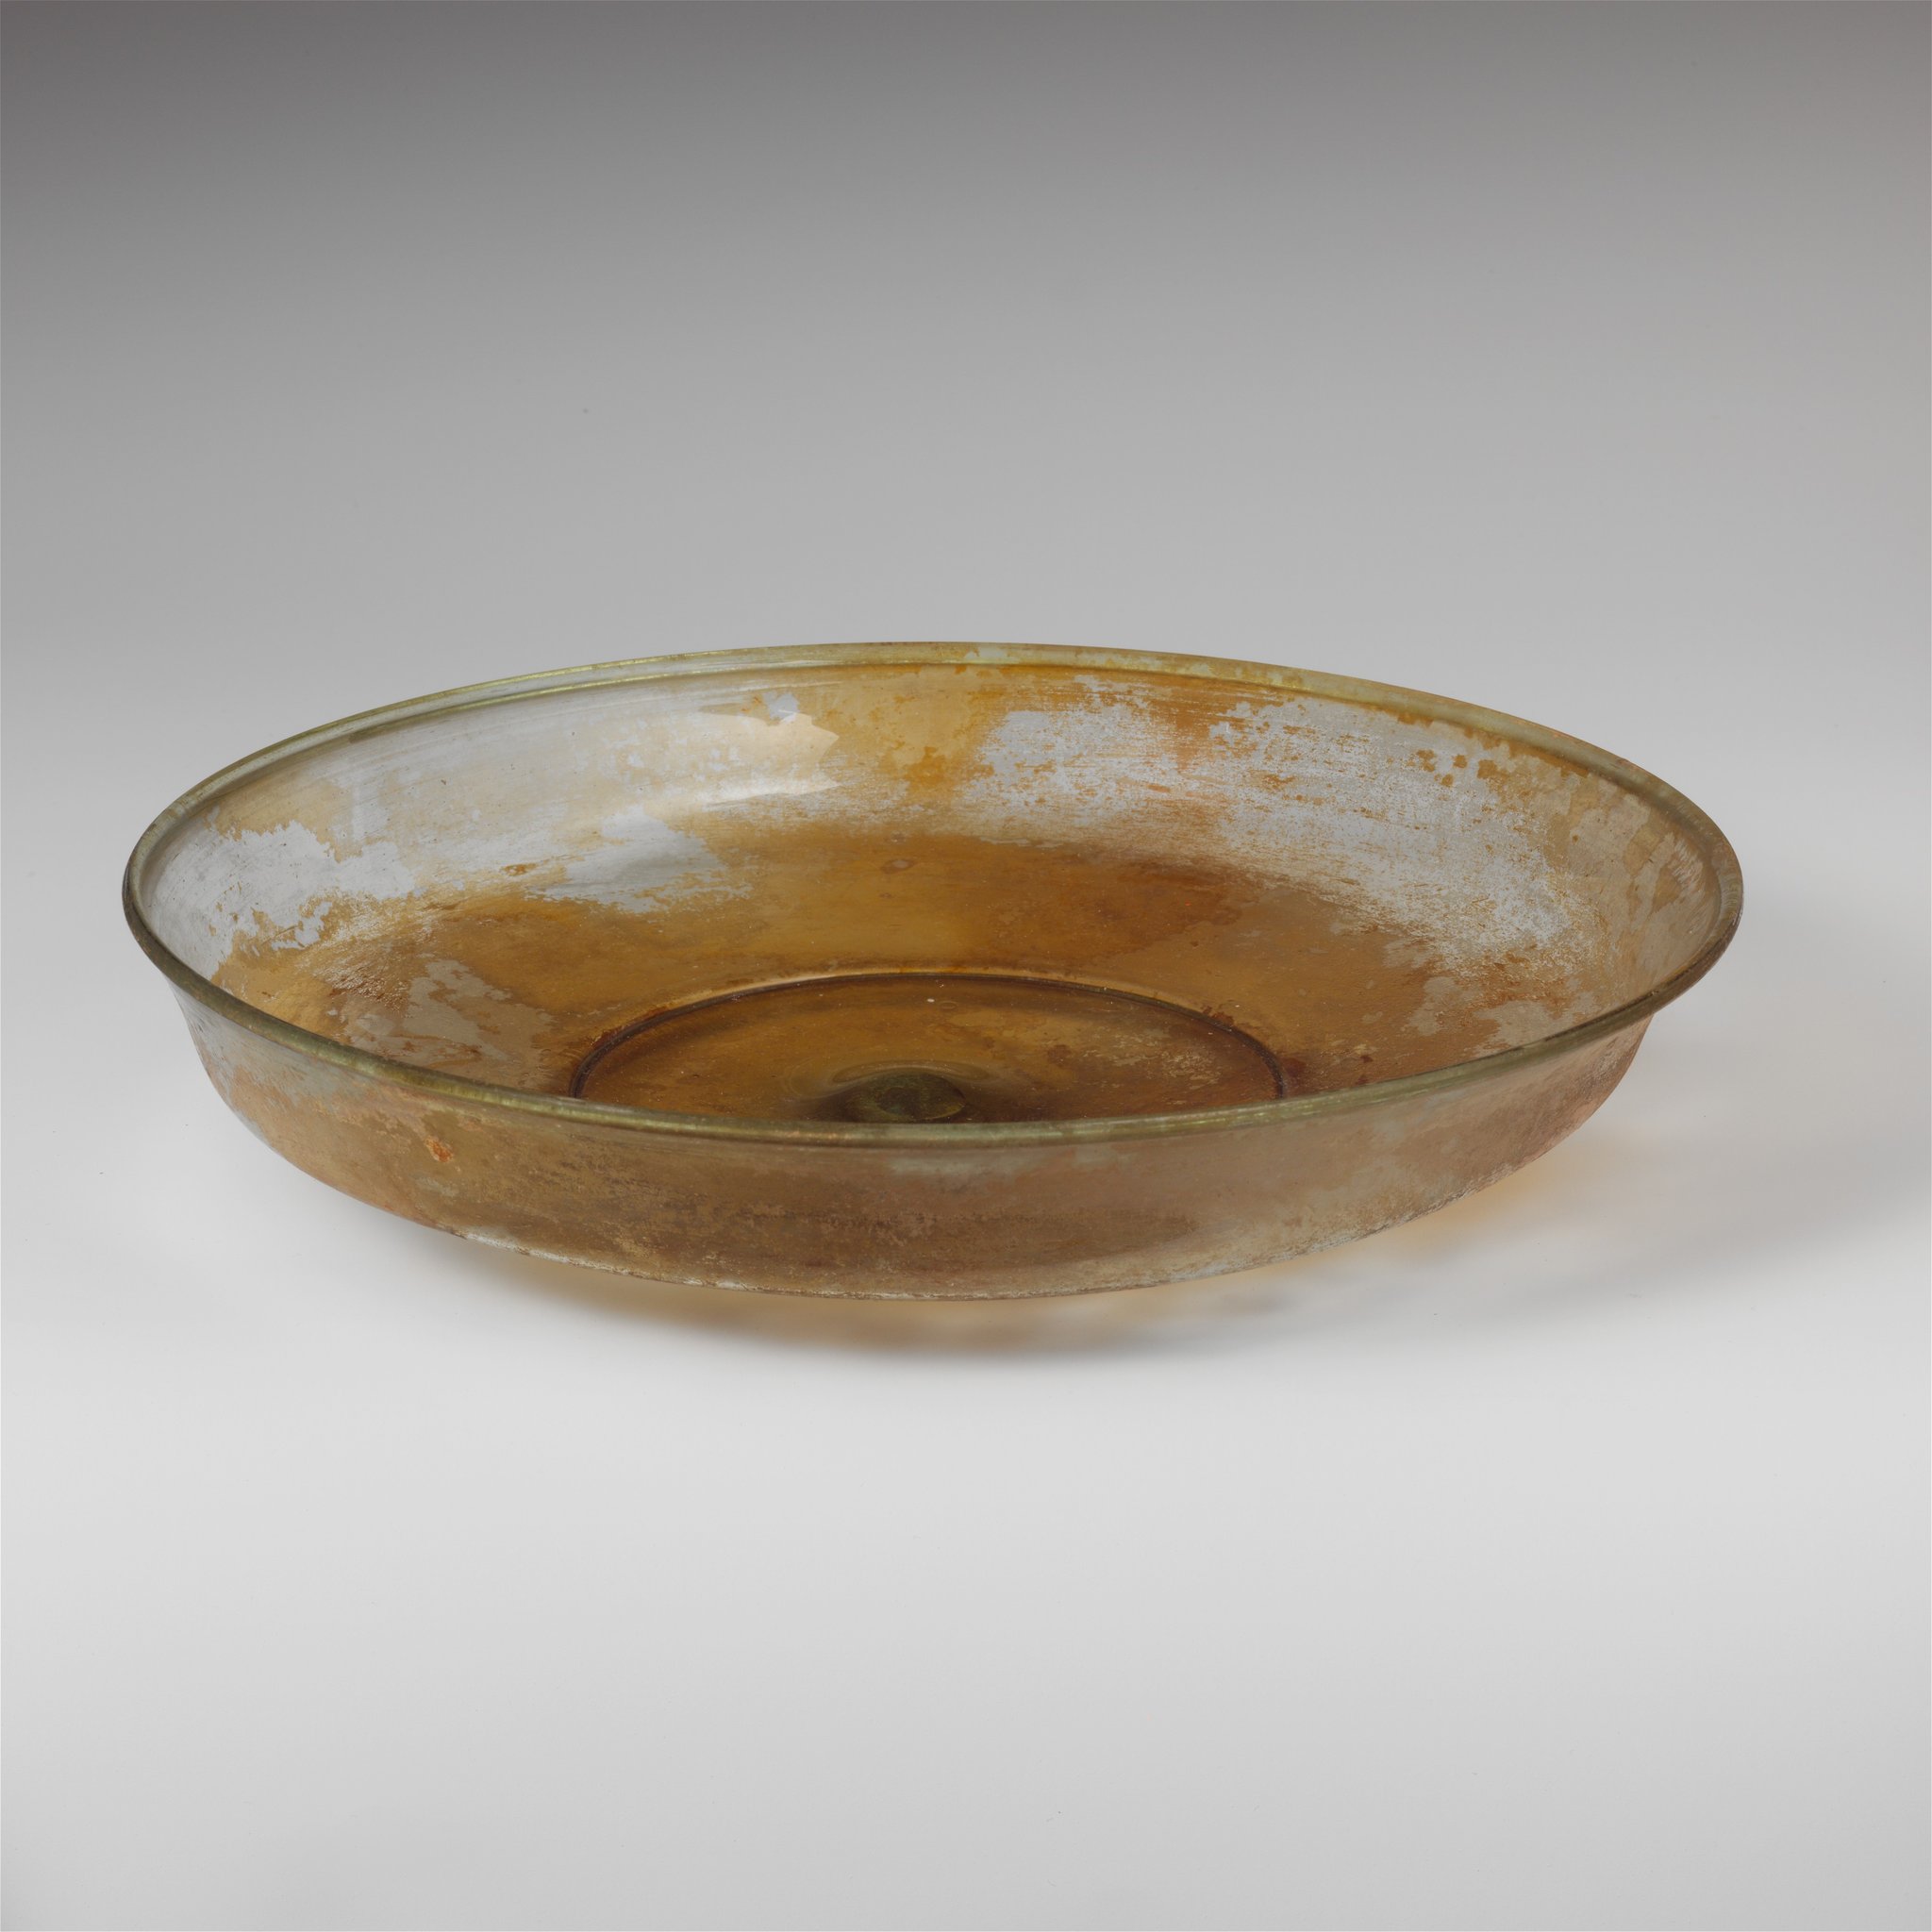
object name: dish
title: Glass dish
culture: roman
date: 301-400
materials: glass